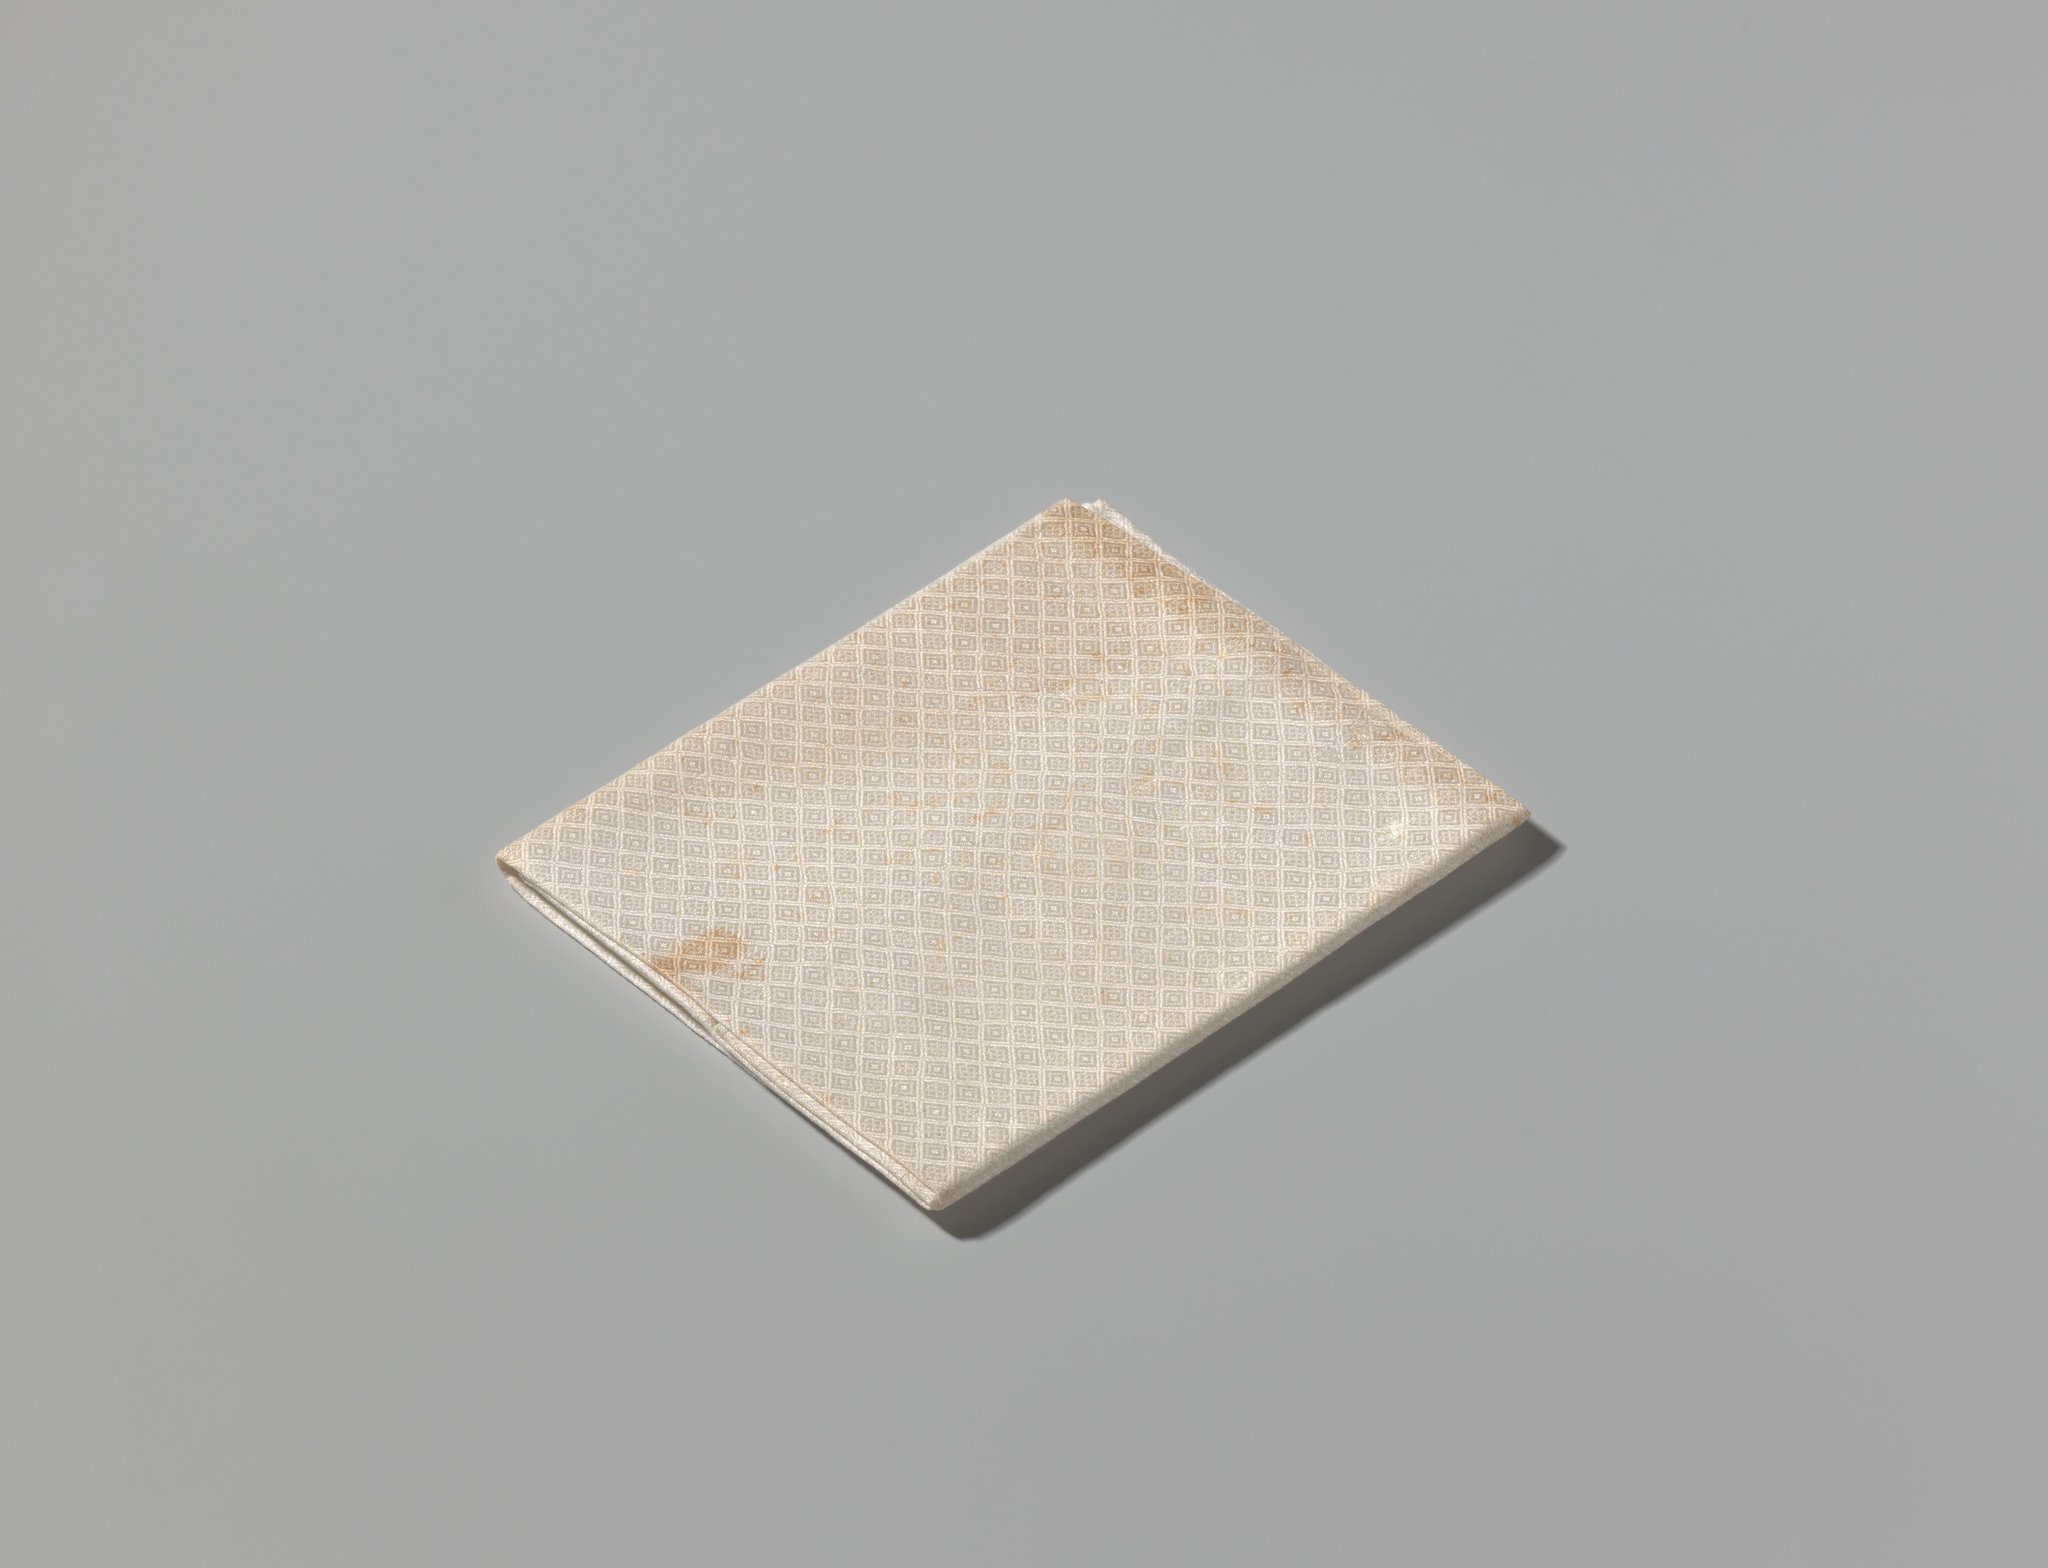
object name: towel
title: Handdoek van wit linnen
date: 1725-1735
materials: linen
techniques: peeled fabric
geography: netherlands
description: Wit linnen servet met een pellen patroon z.g. ,kraanoog' en randen rondom WH 2oonl.